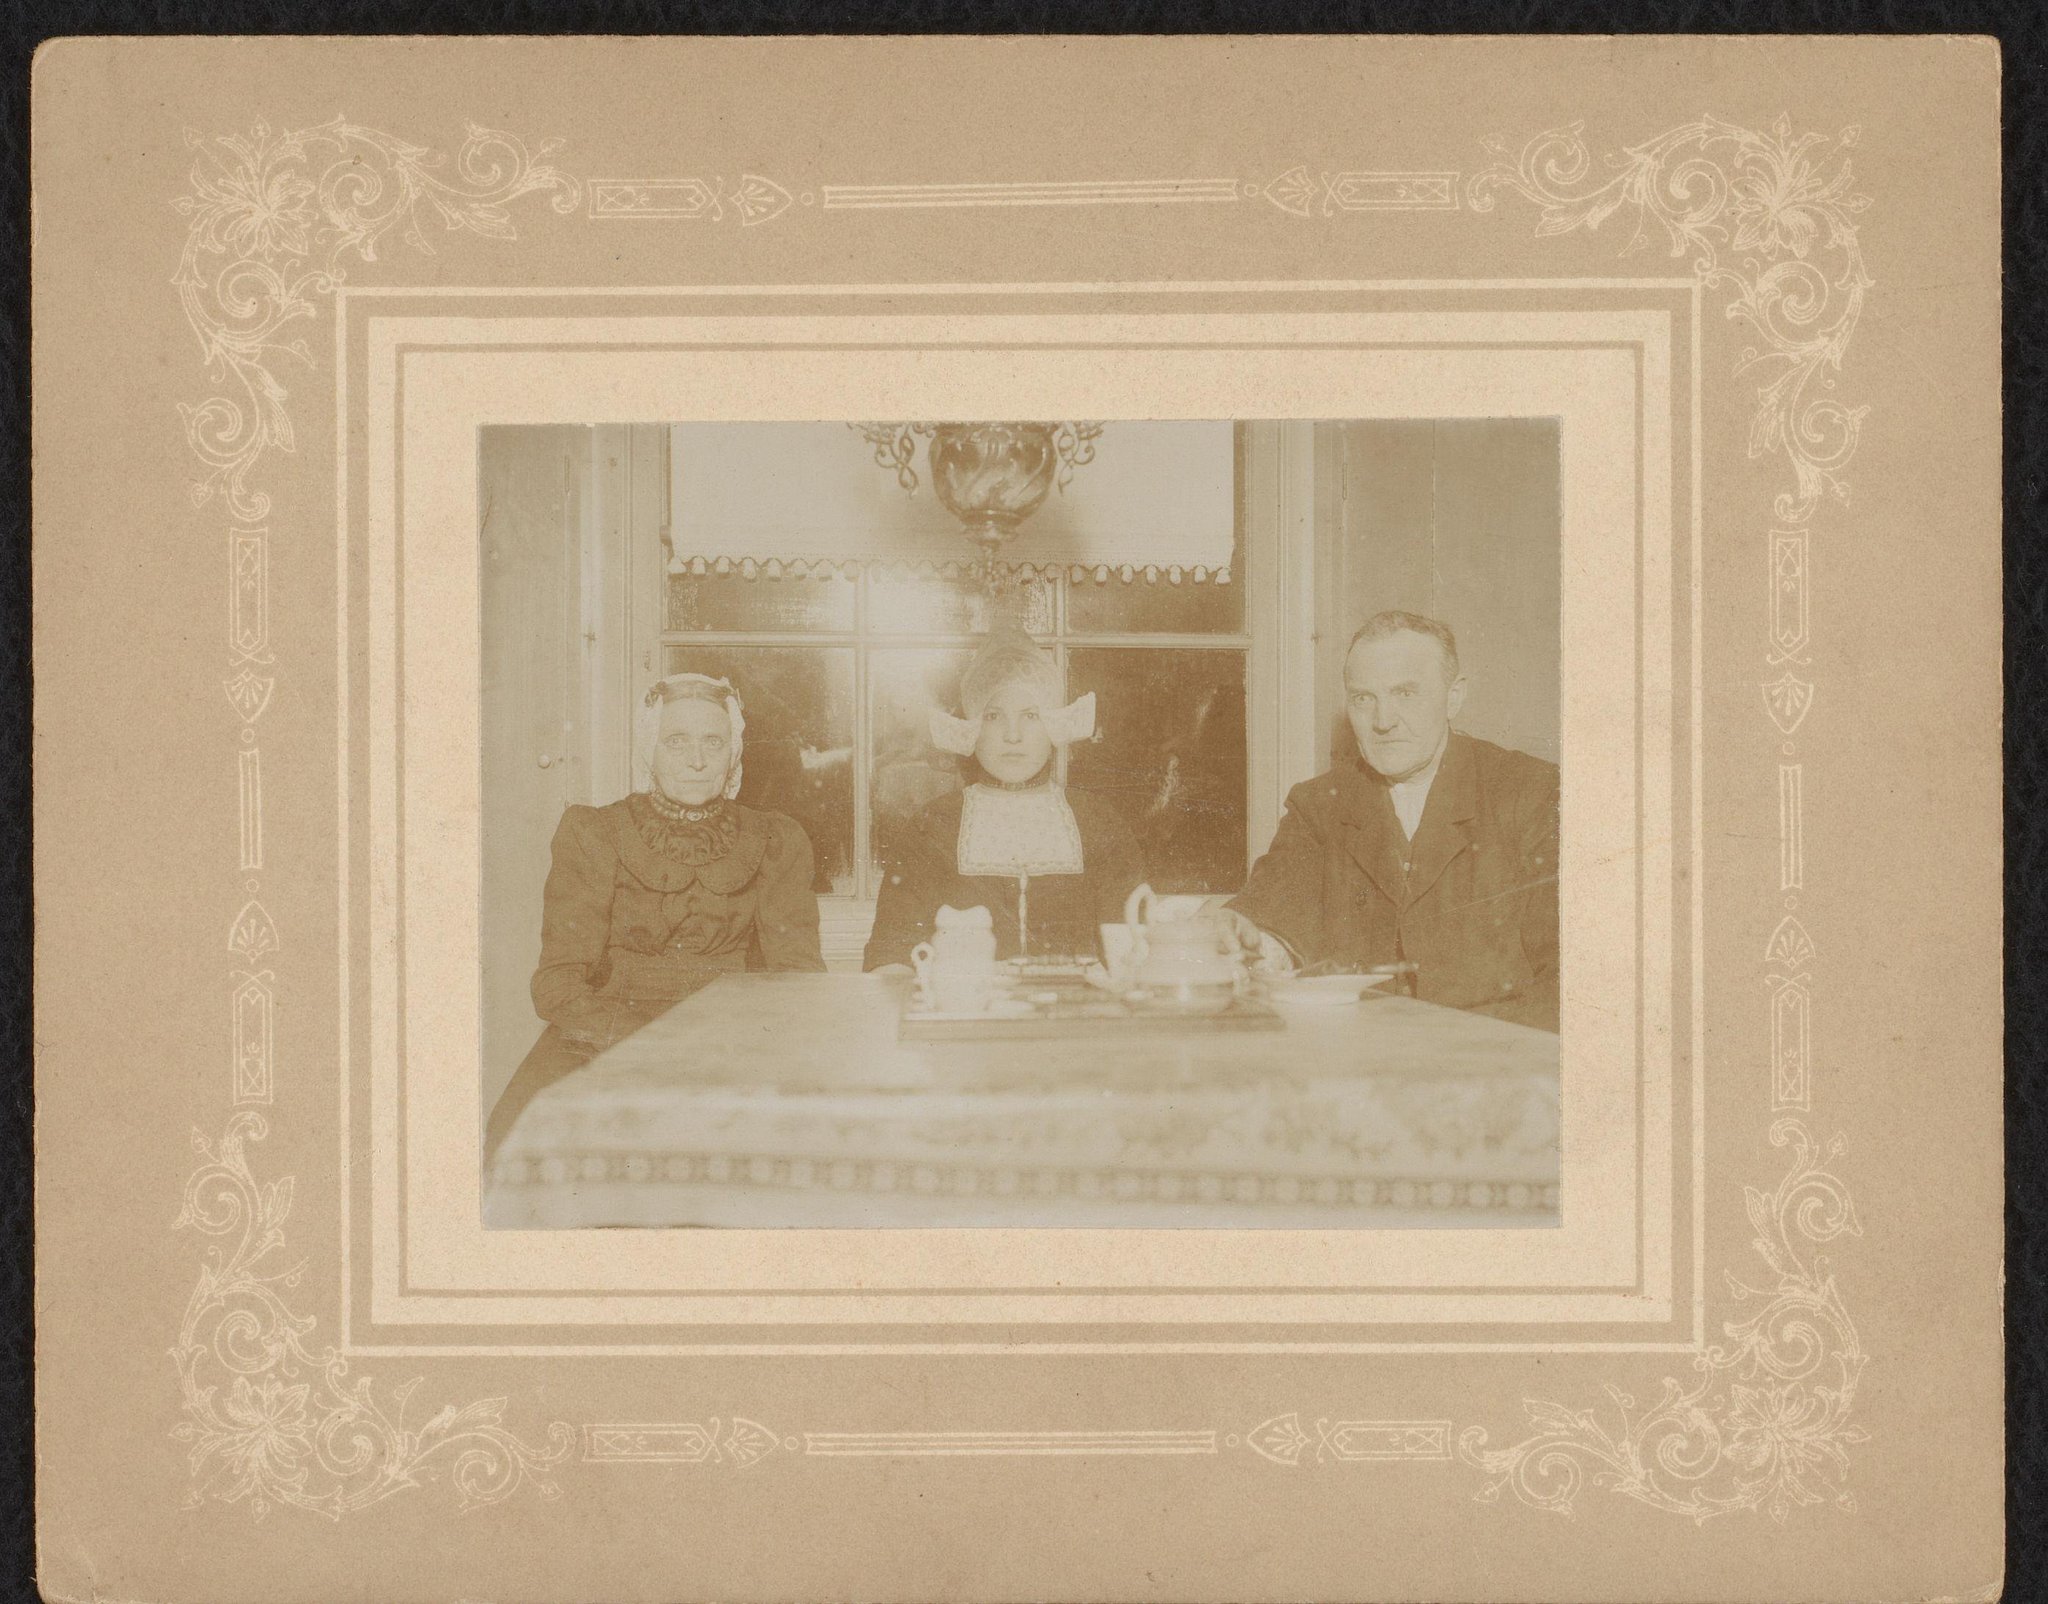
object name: photograph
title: Portret van een man en twee vrouwen in klederdracht, zittend aan een keukentafel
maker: Anonymous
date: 1880-1930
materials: cardboard, photographic support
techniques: collodion silver print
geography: netherlands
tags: adult man, adult woman (+ two persons), folk costume, regional costume, anonymous historical persons portrayed in a group, in a group-portrait